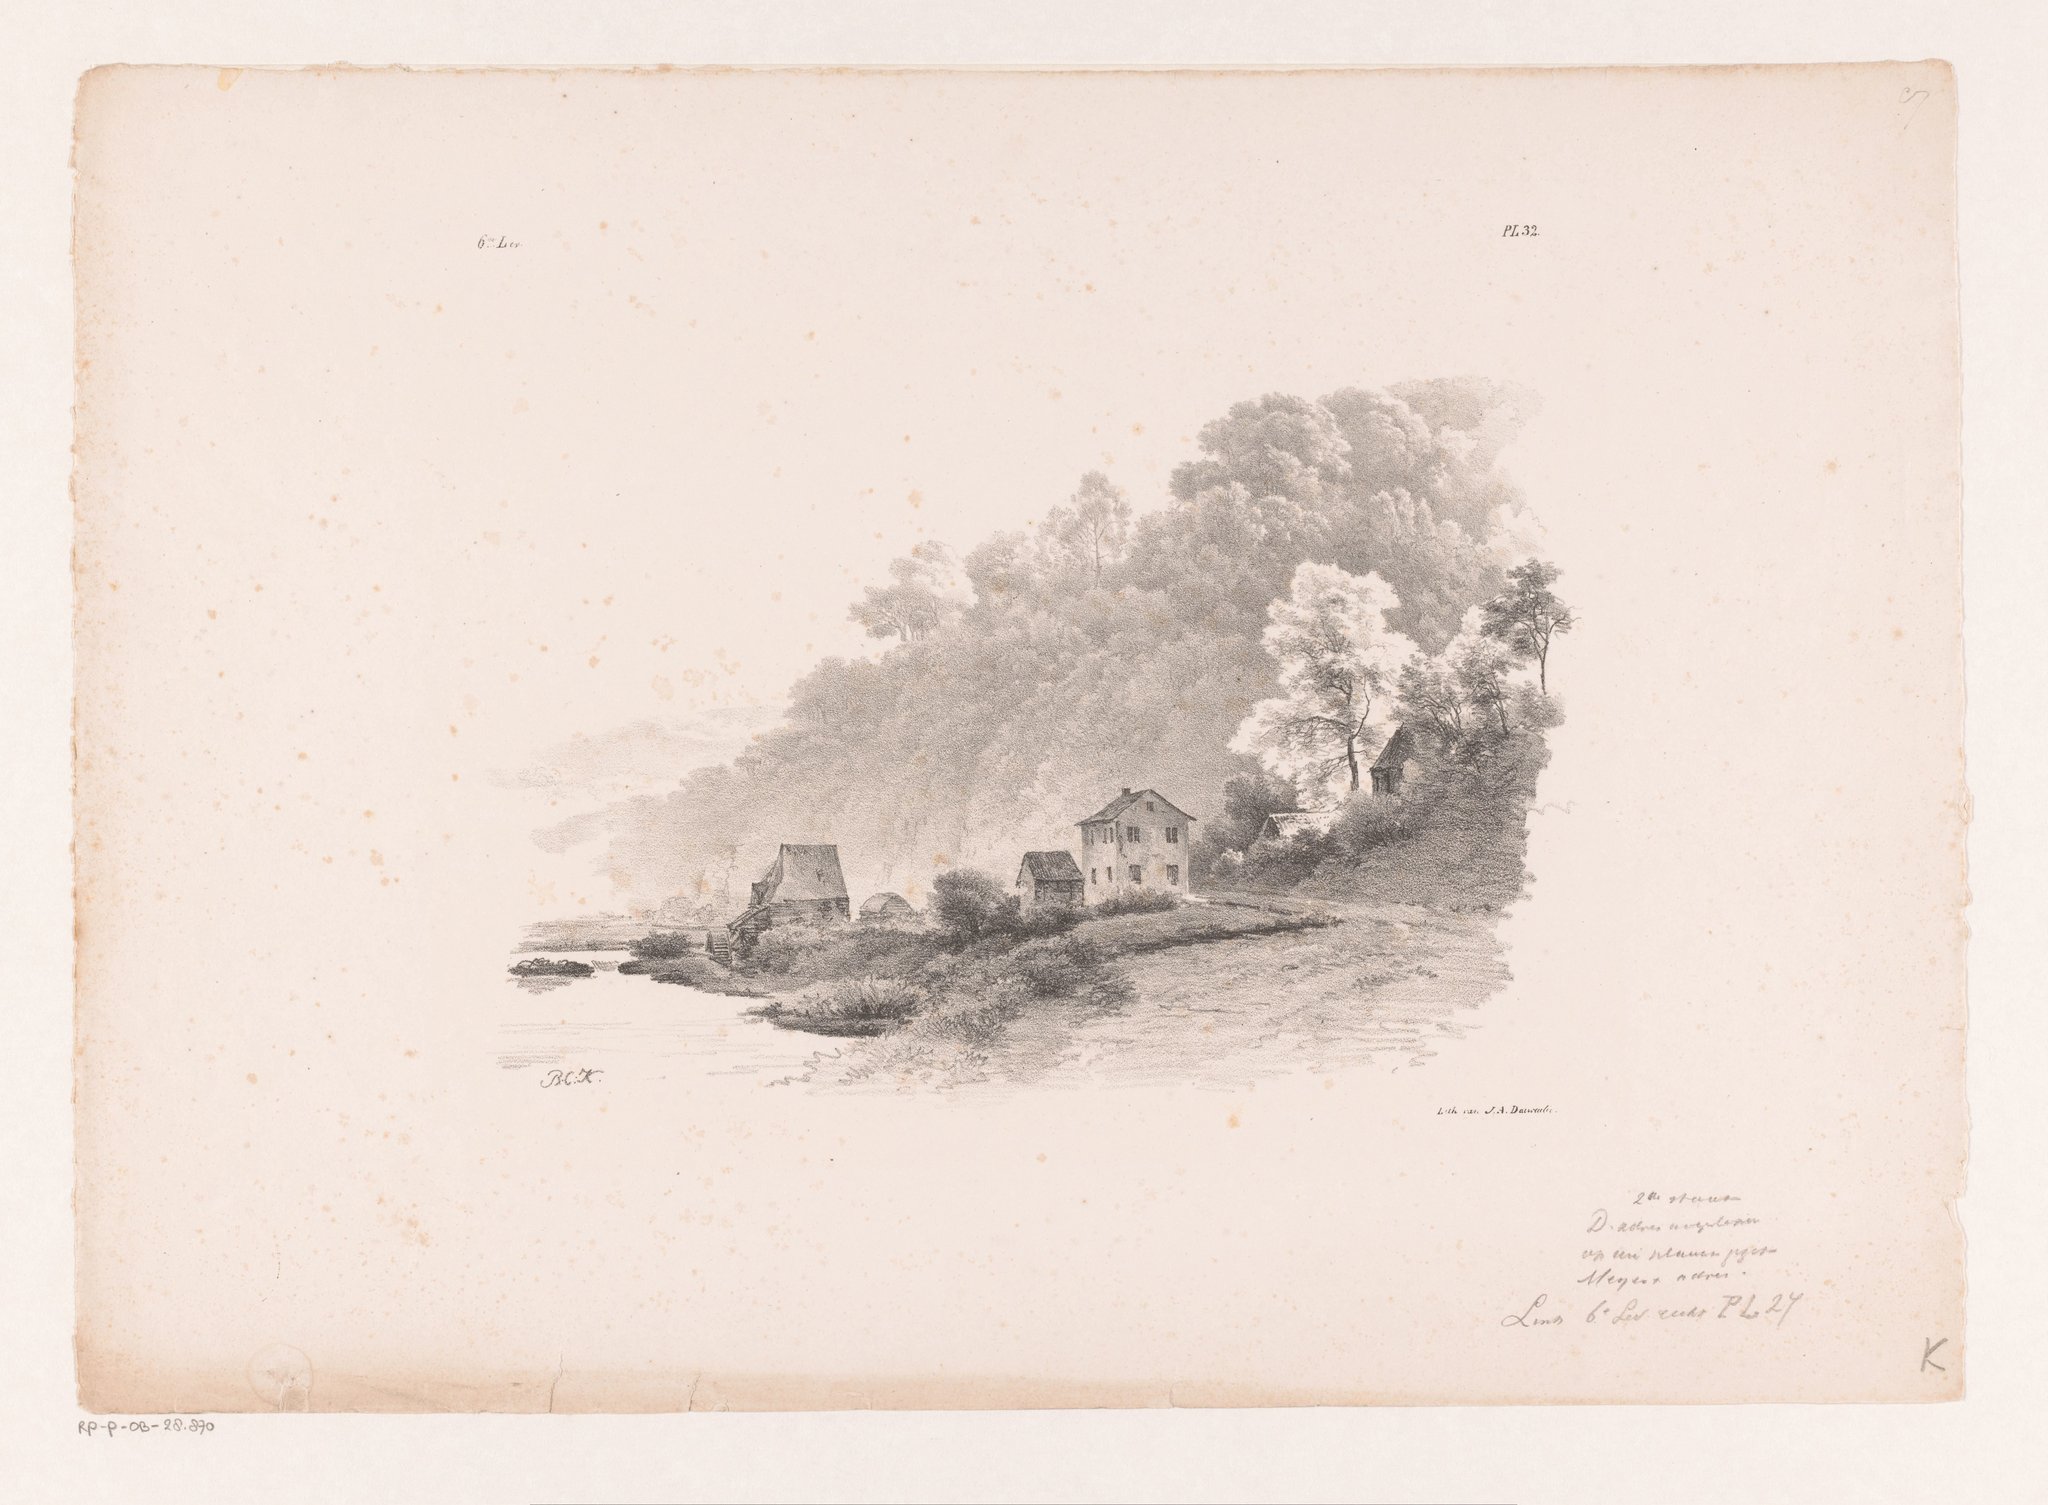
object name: print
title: Landschap studiën zesde levering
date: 1829-1830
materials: paper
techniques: lithograph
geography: amsterdam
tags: low hill country, river, watermill in landscape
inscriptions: collector's mark: Lugt 2228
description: In 1829 en 1830 gaf Koekkoek, samen met Daiwaille, zes cahiers uit met ieder zes prenten getiteld Landschapstudiën. Deze werden gebruikt in het tekenonderwijs. Vijftien jaar later werd deze reeks, in een andere samenstelling nogmaals uitgegeven door Meyer en Comp in Amsterdam. Zie: De Bruyn Kops, 1963.